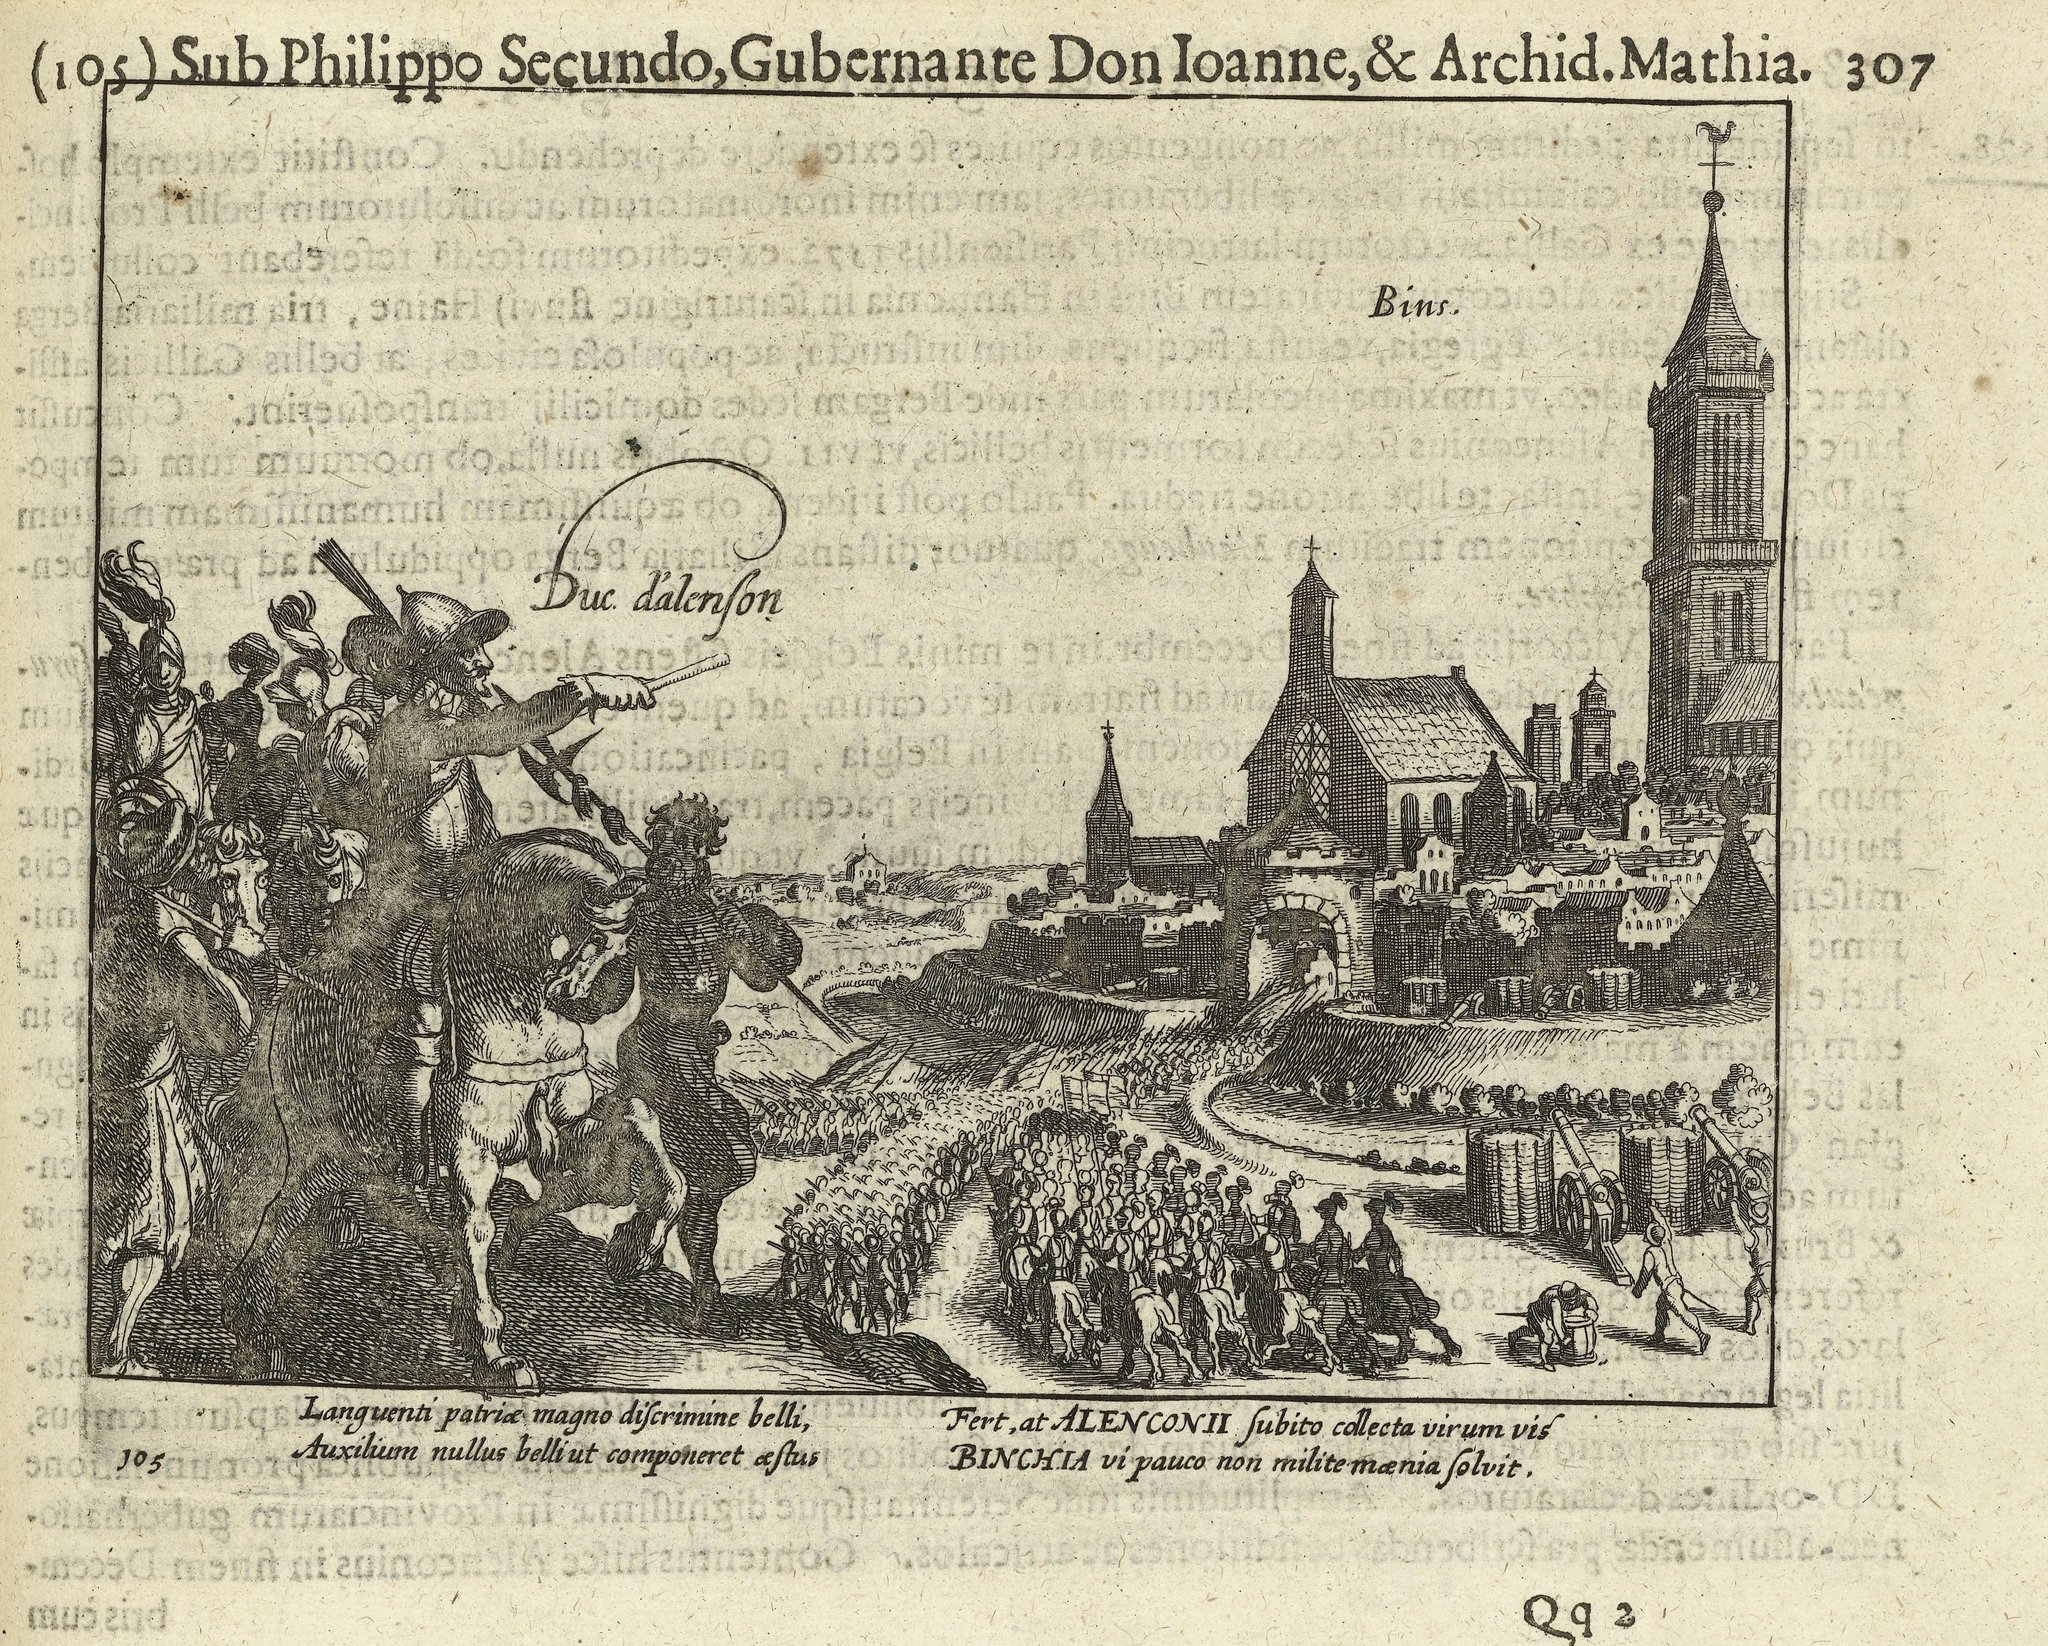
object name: history print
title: Hertog van Anjou neemt Binche in, 1578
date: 1613-1615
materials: paper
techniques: etching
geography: northern netherlands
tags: paris, françois-hercule de valois (hertog van anjou), capture of city (after the siege), binche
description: Na beleg geeft de stad Binche zich over aan de hertog van Anjou, 7 oktober 1578. Op de voorgrond de hertog van Anjou te paard, daarachter trekken zijn legers de stad in. Met onderschrift van 4 regels in het Latijn. Genummerd: 105. Bedrukt op achterzijde met tekst in het Latijn.